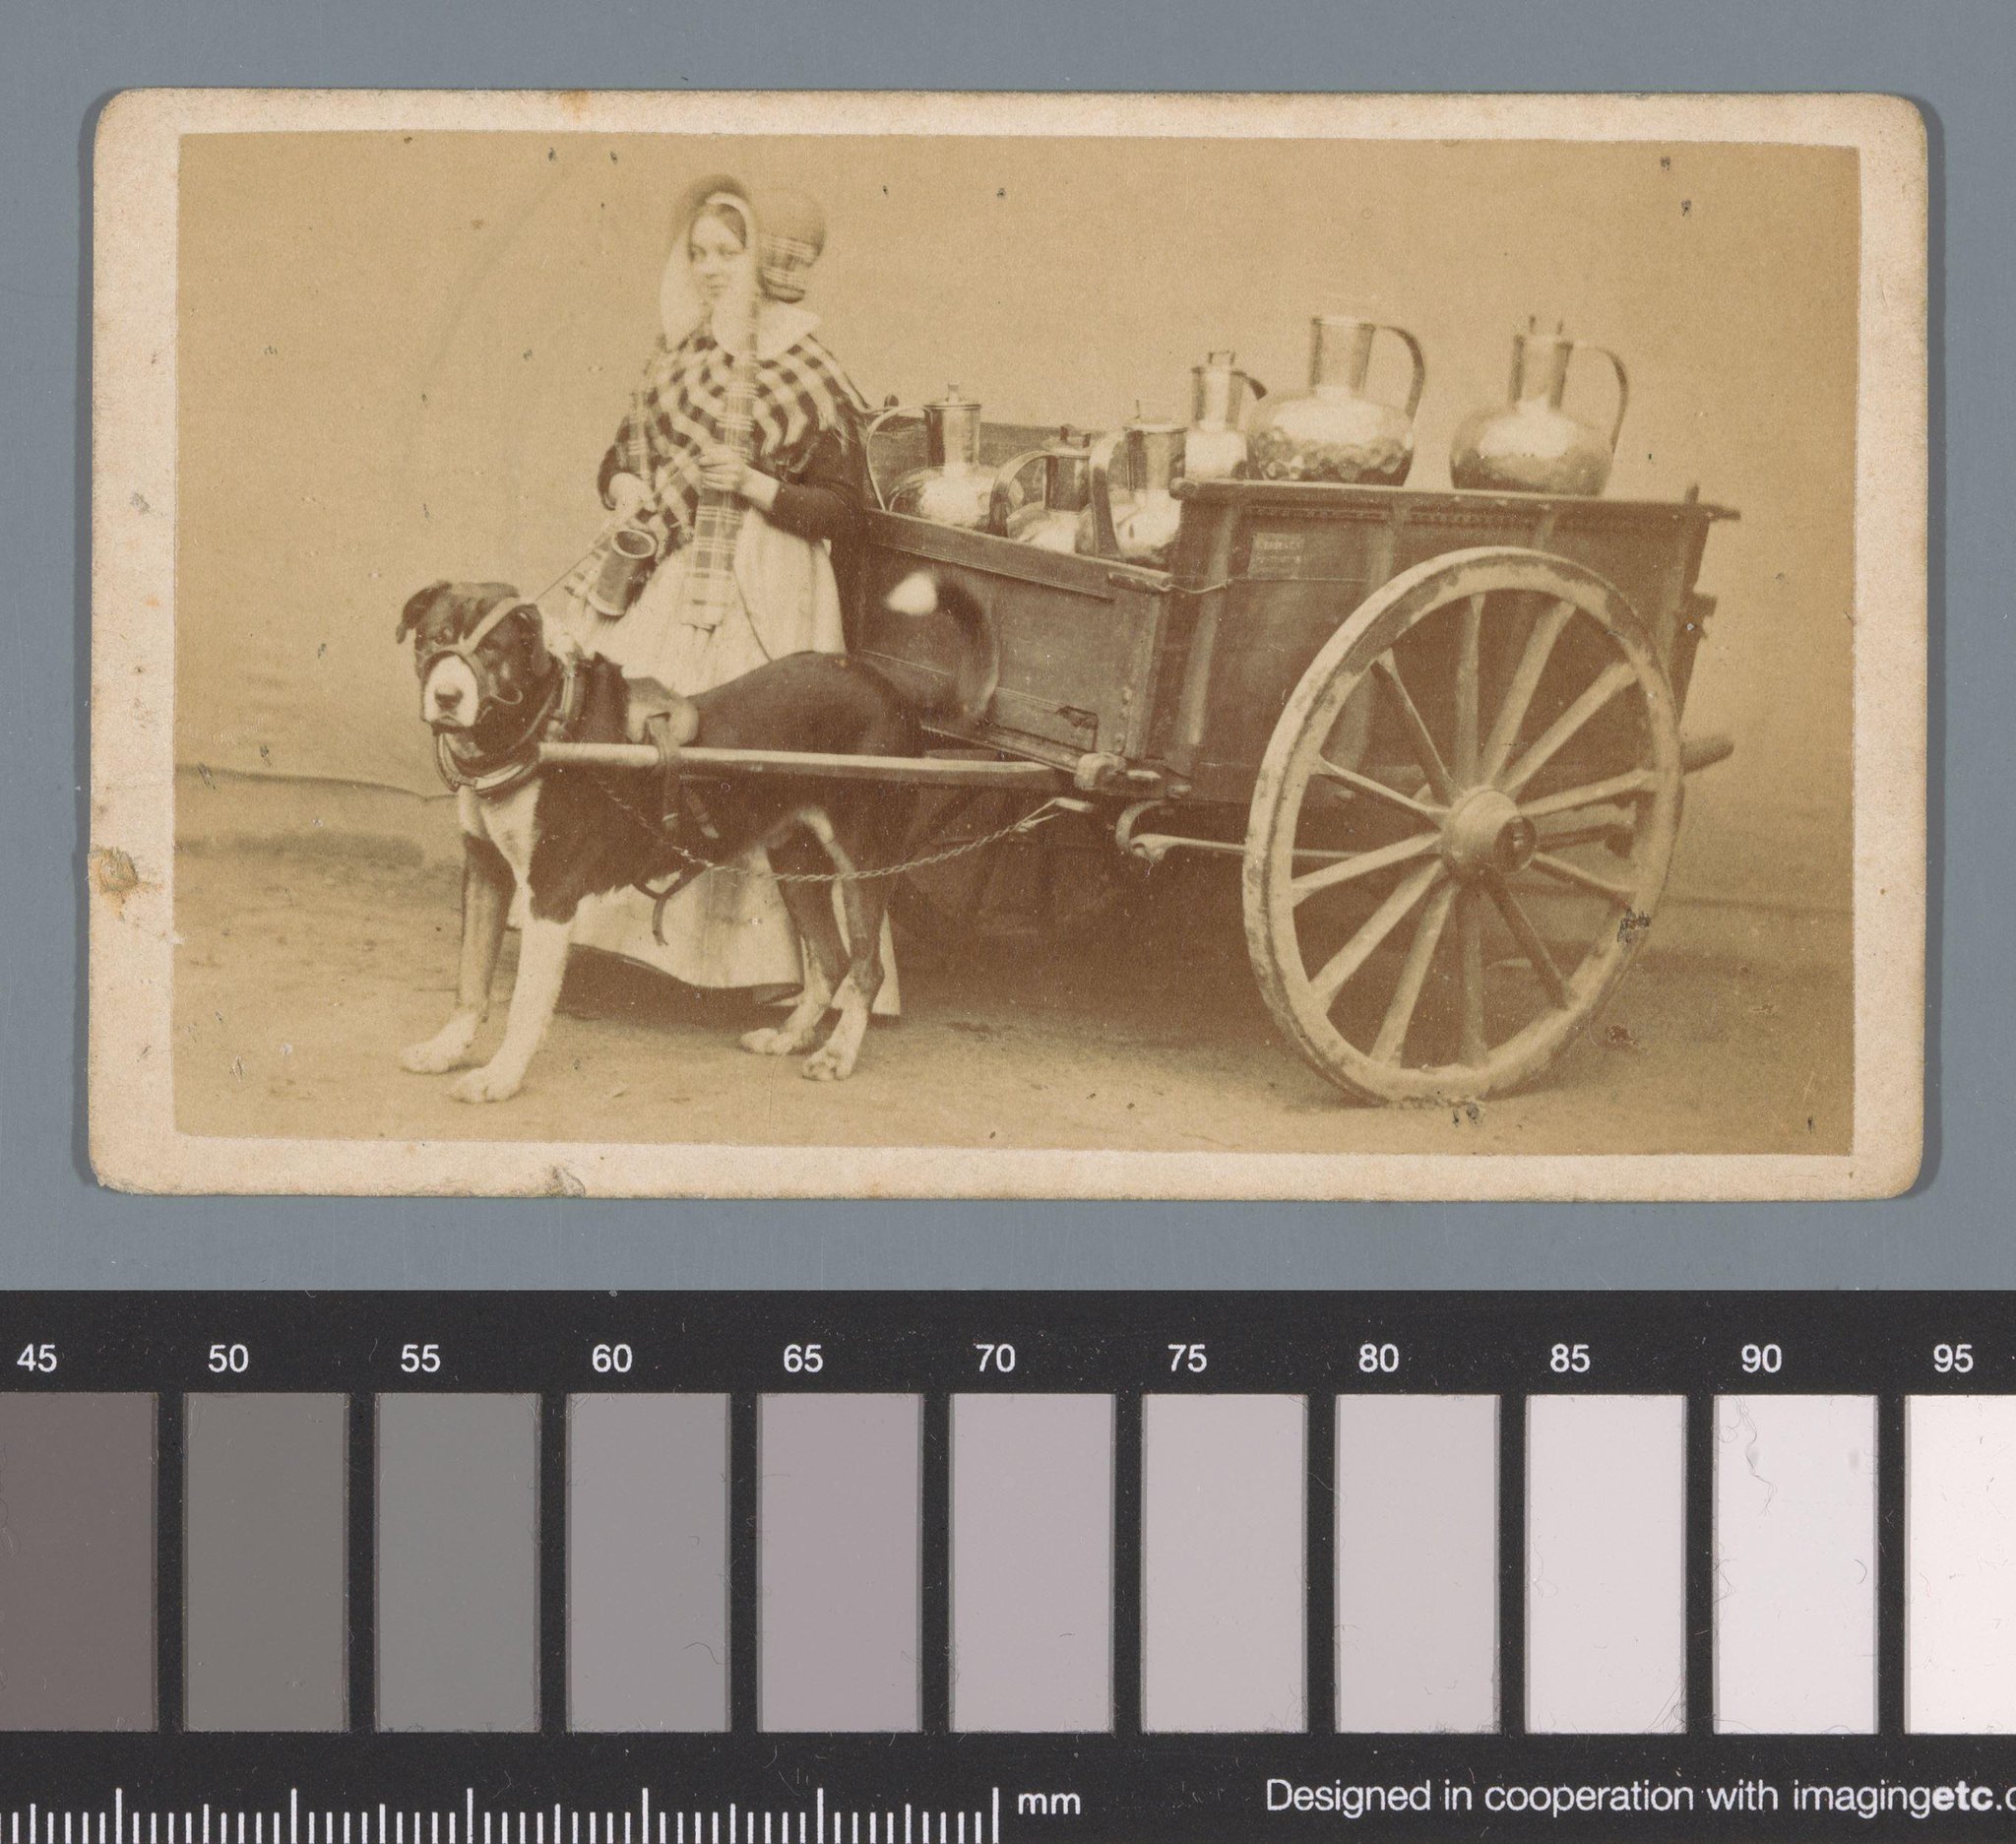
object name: photograph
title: Portret van een onbekende vrouw in klederdracht met een hondenkar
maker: Anonymous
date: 1870-1890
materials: cardboard, photographic support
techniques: albumen print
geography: netherlands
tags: two-wheeled, animal-drawn vehicle, folk costume, regional costume, dog